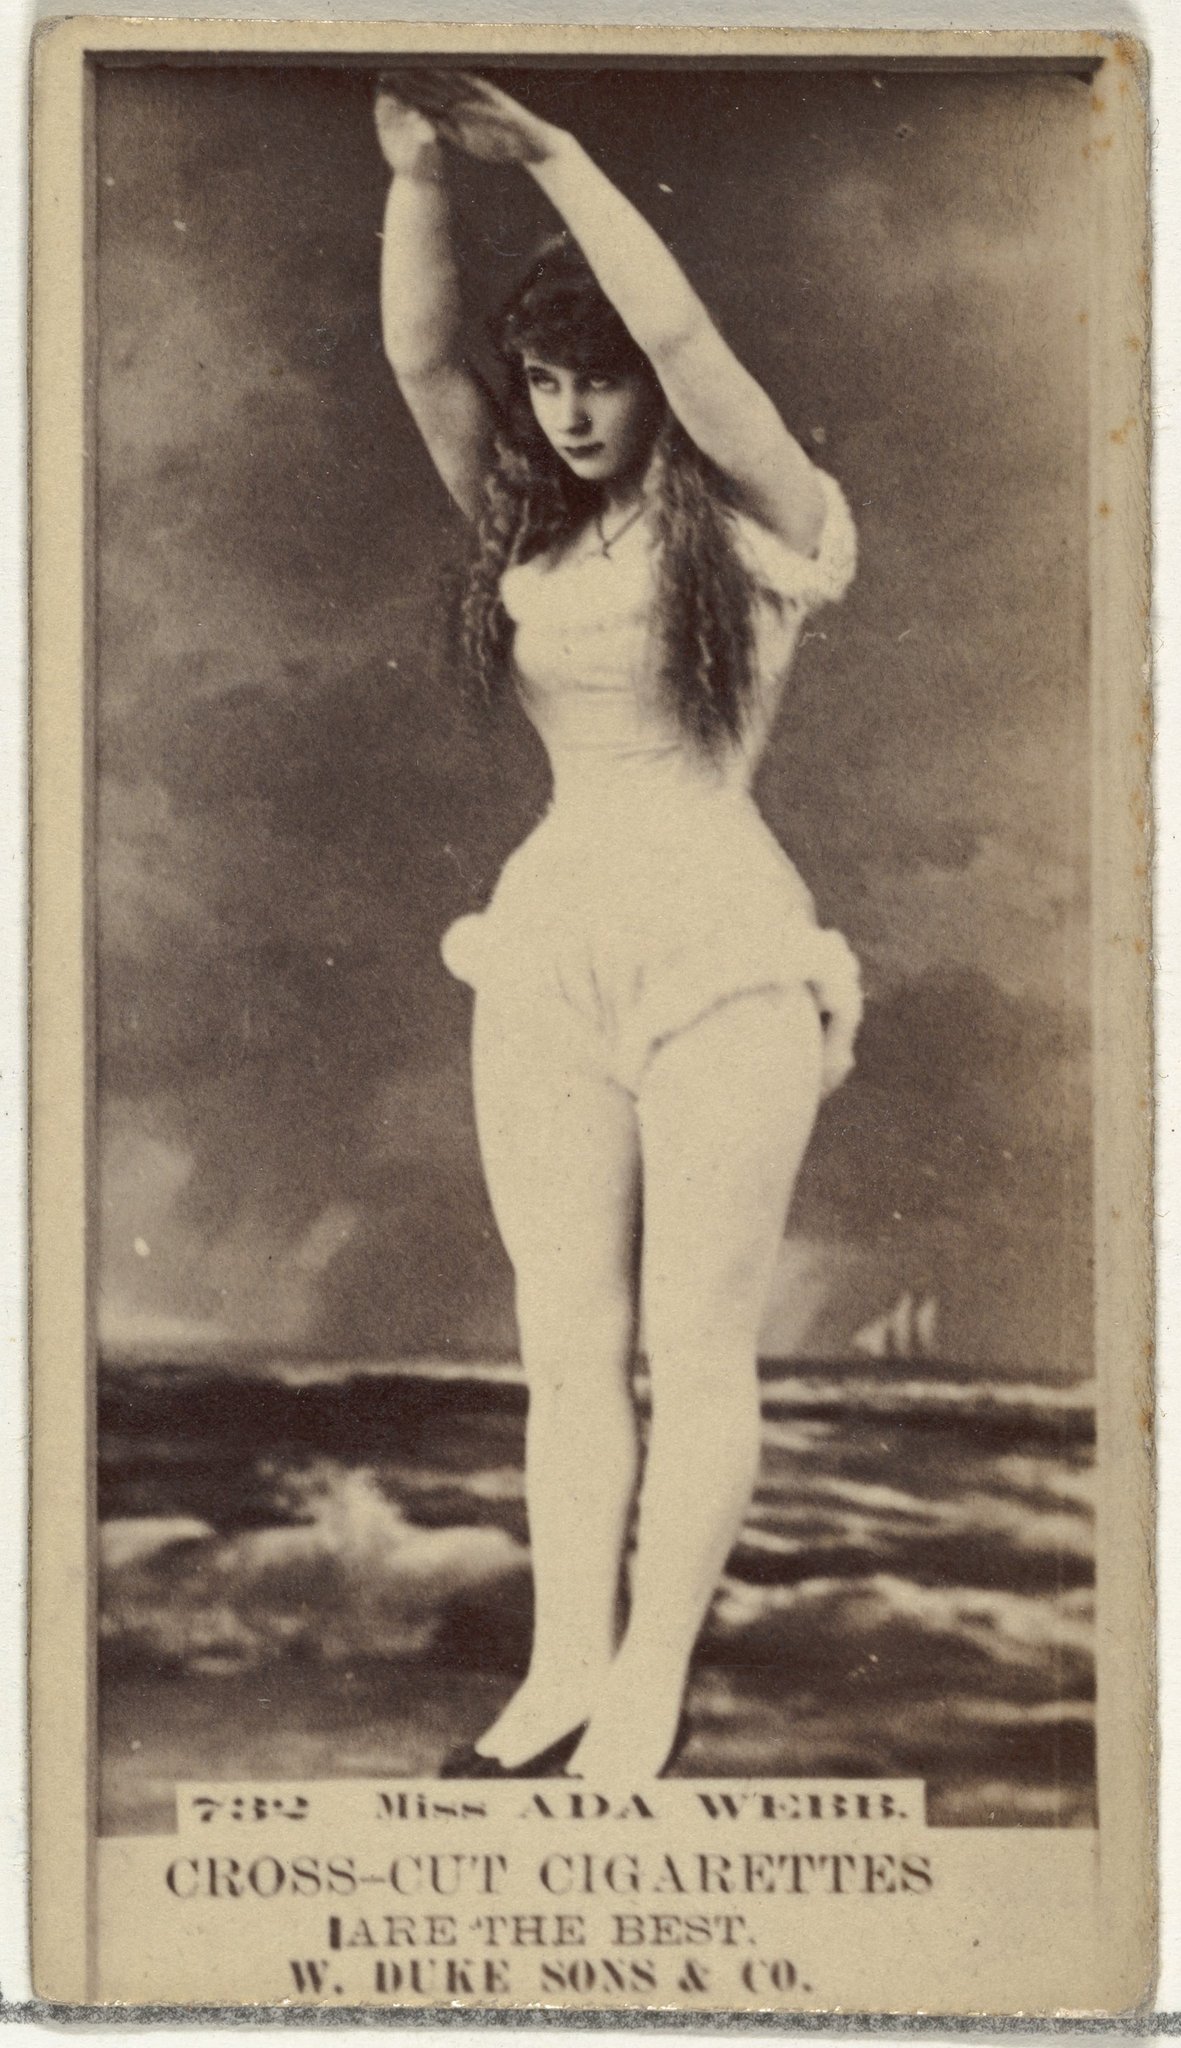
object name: photograph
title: Card Number 732, Ada Webb, from the Actors and Actresses series (N145-3) issued by Duke Sons & Co. to promote Cross Cut Cigarettes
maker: w. duke, sons & co.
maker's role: publisher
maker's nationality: american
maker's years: 1870-1920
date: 1880-1889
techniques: albumen silver print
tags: portraits,women,actresses